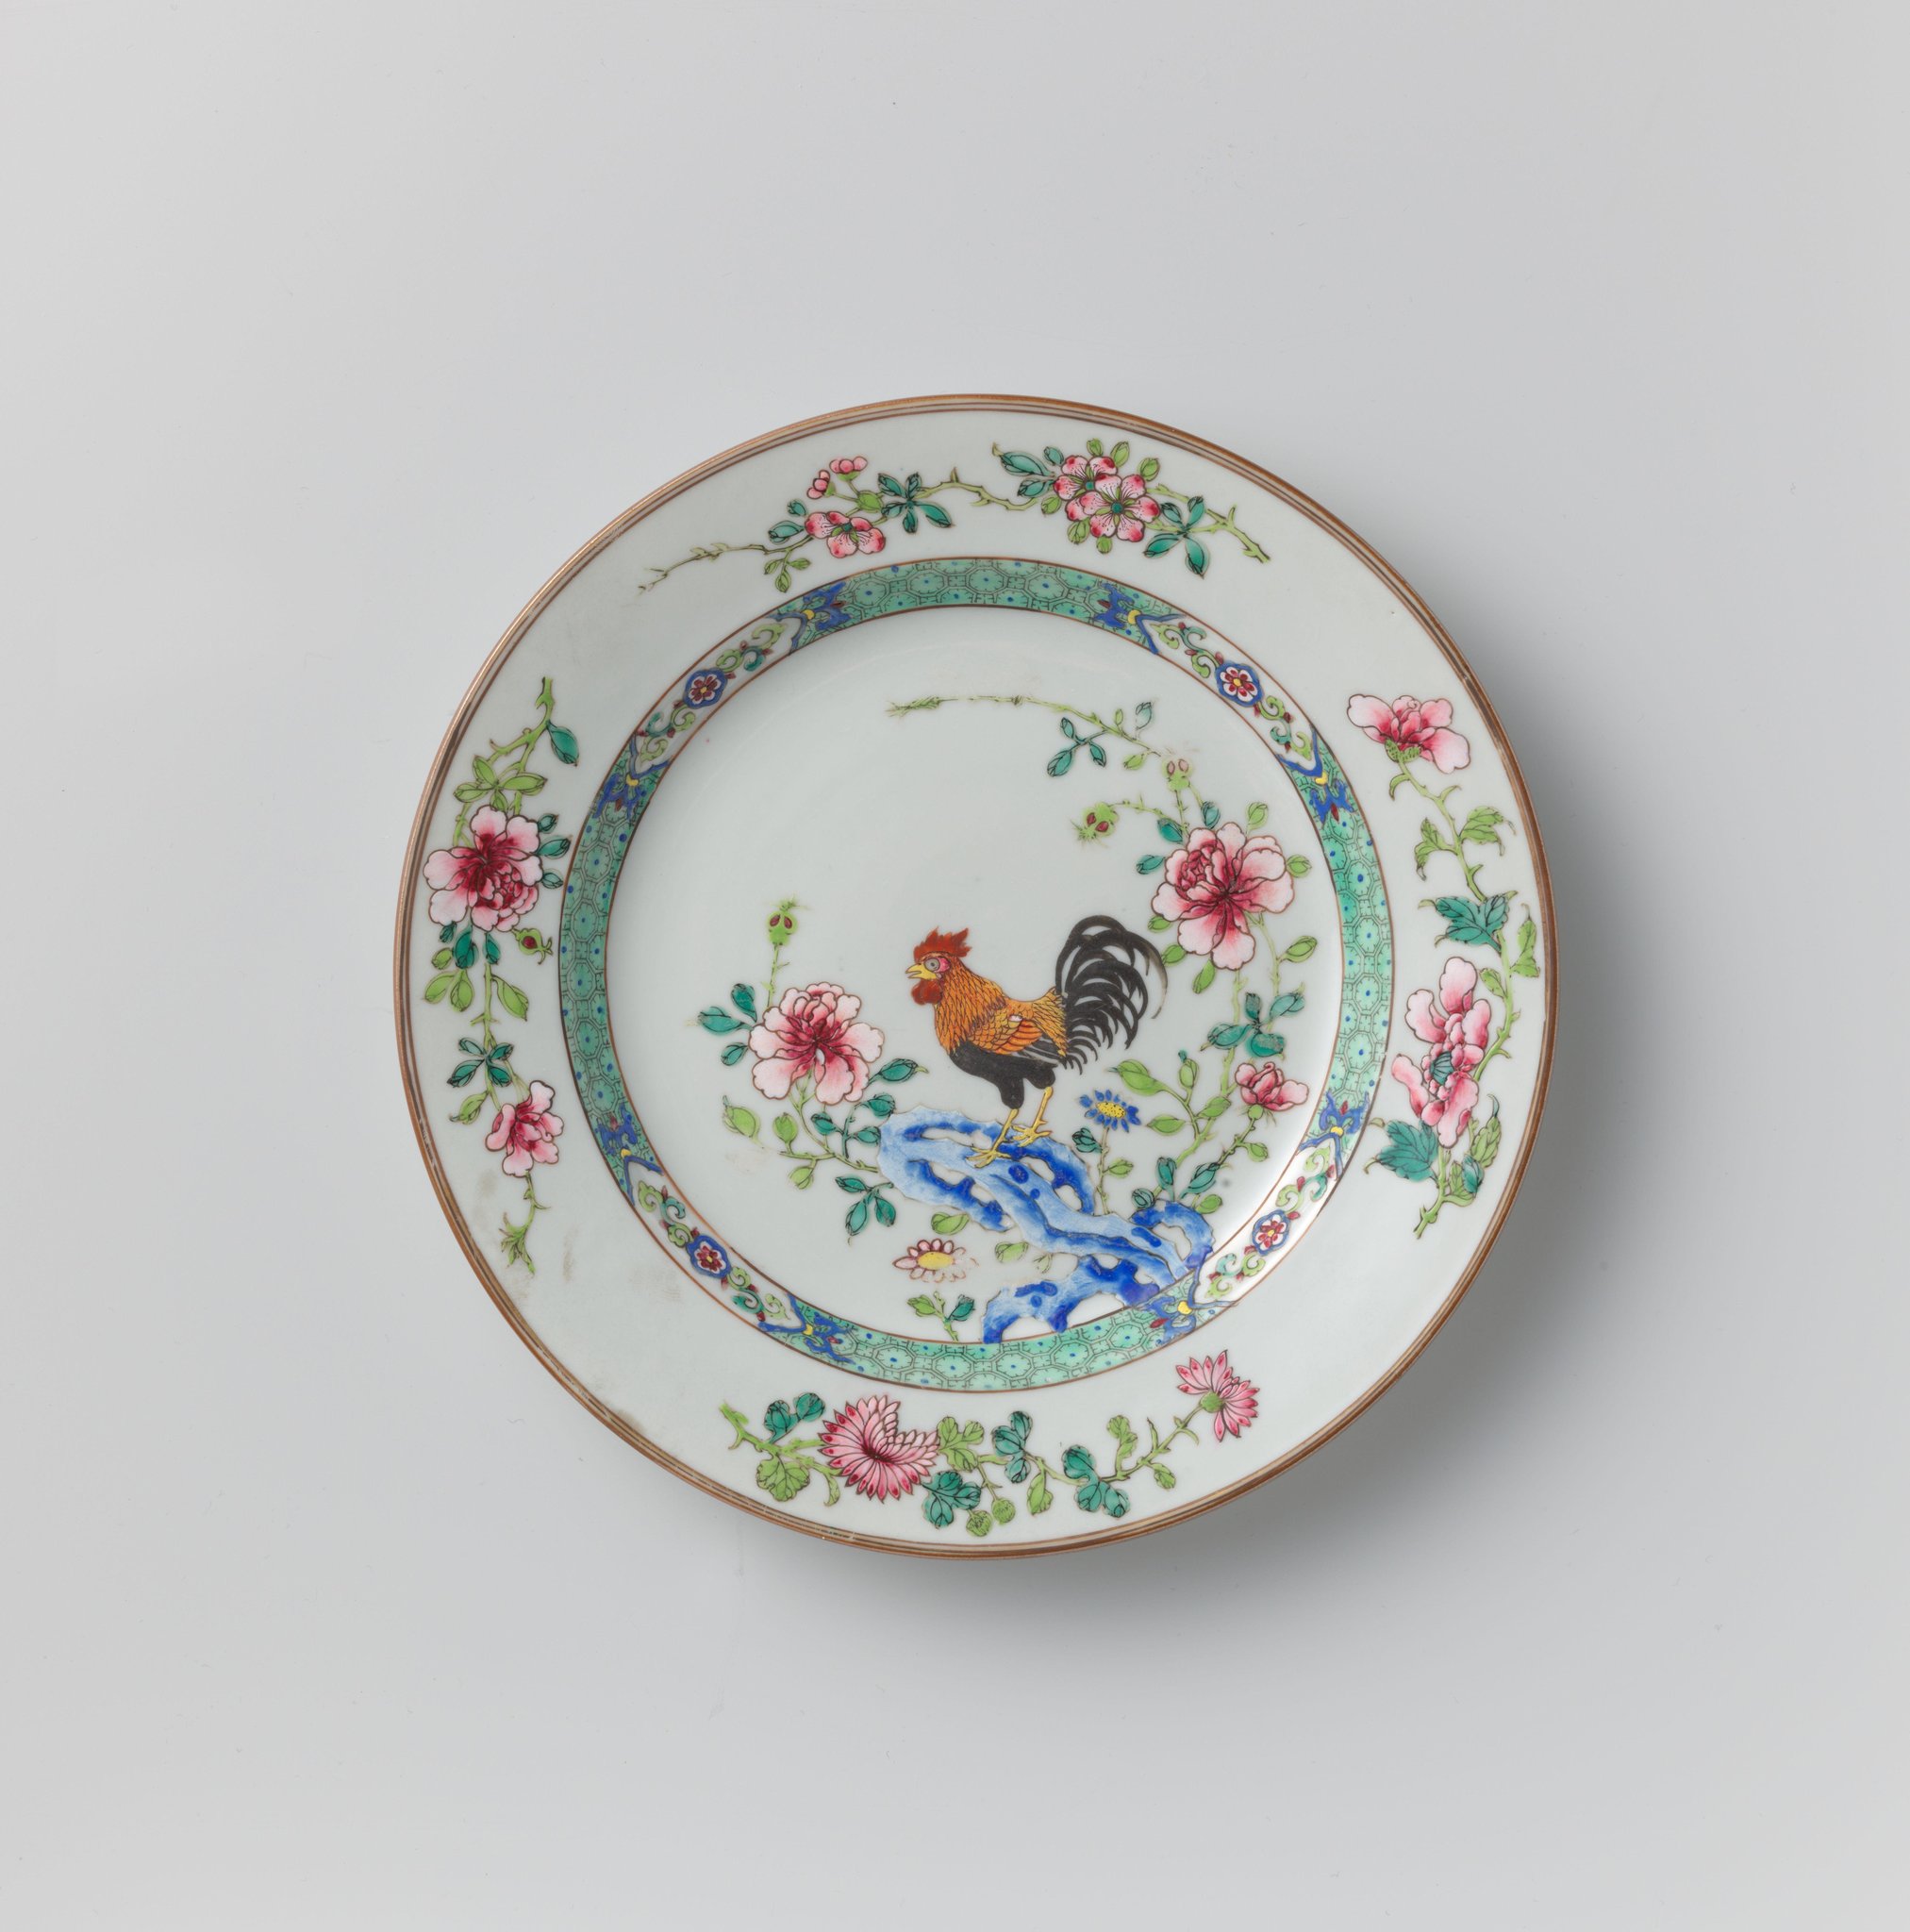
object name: plate dish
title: Plate with a cock on a rock near flowering plants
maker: Anonymous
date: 1725-1749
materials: glaze, paint, porcelain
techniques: firing, turning, vitrification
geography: china